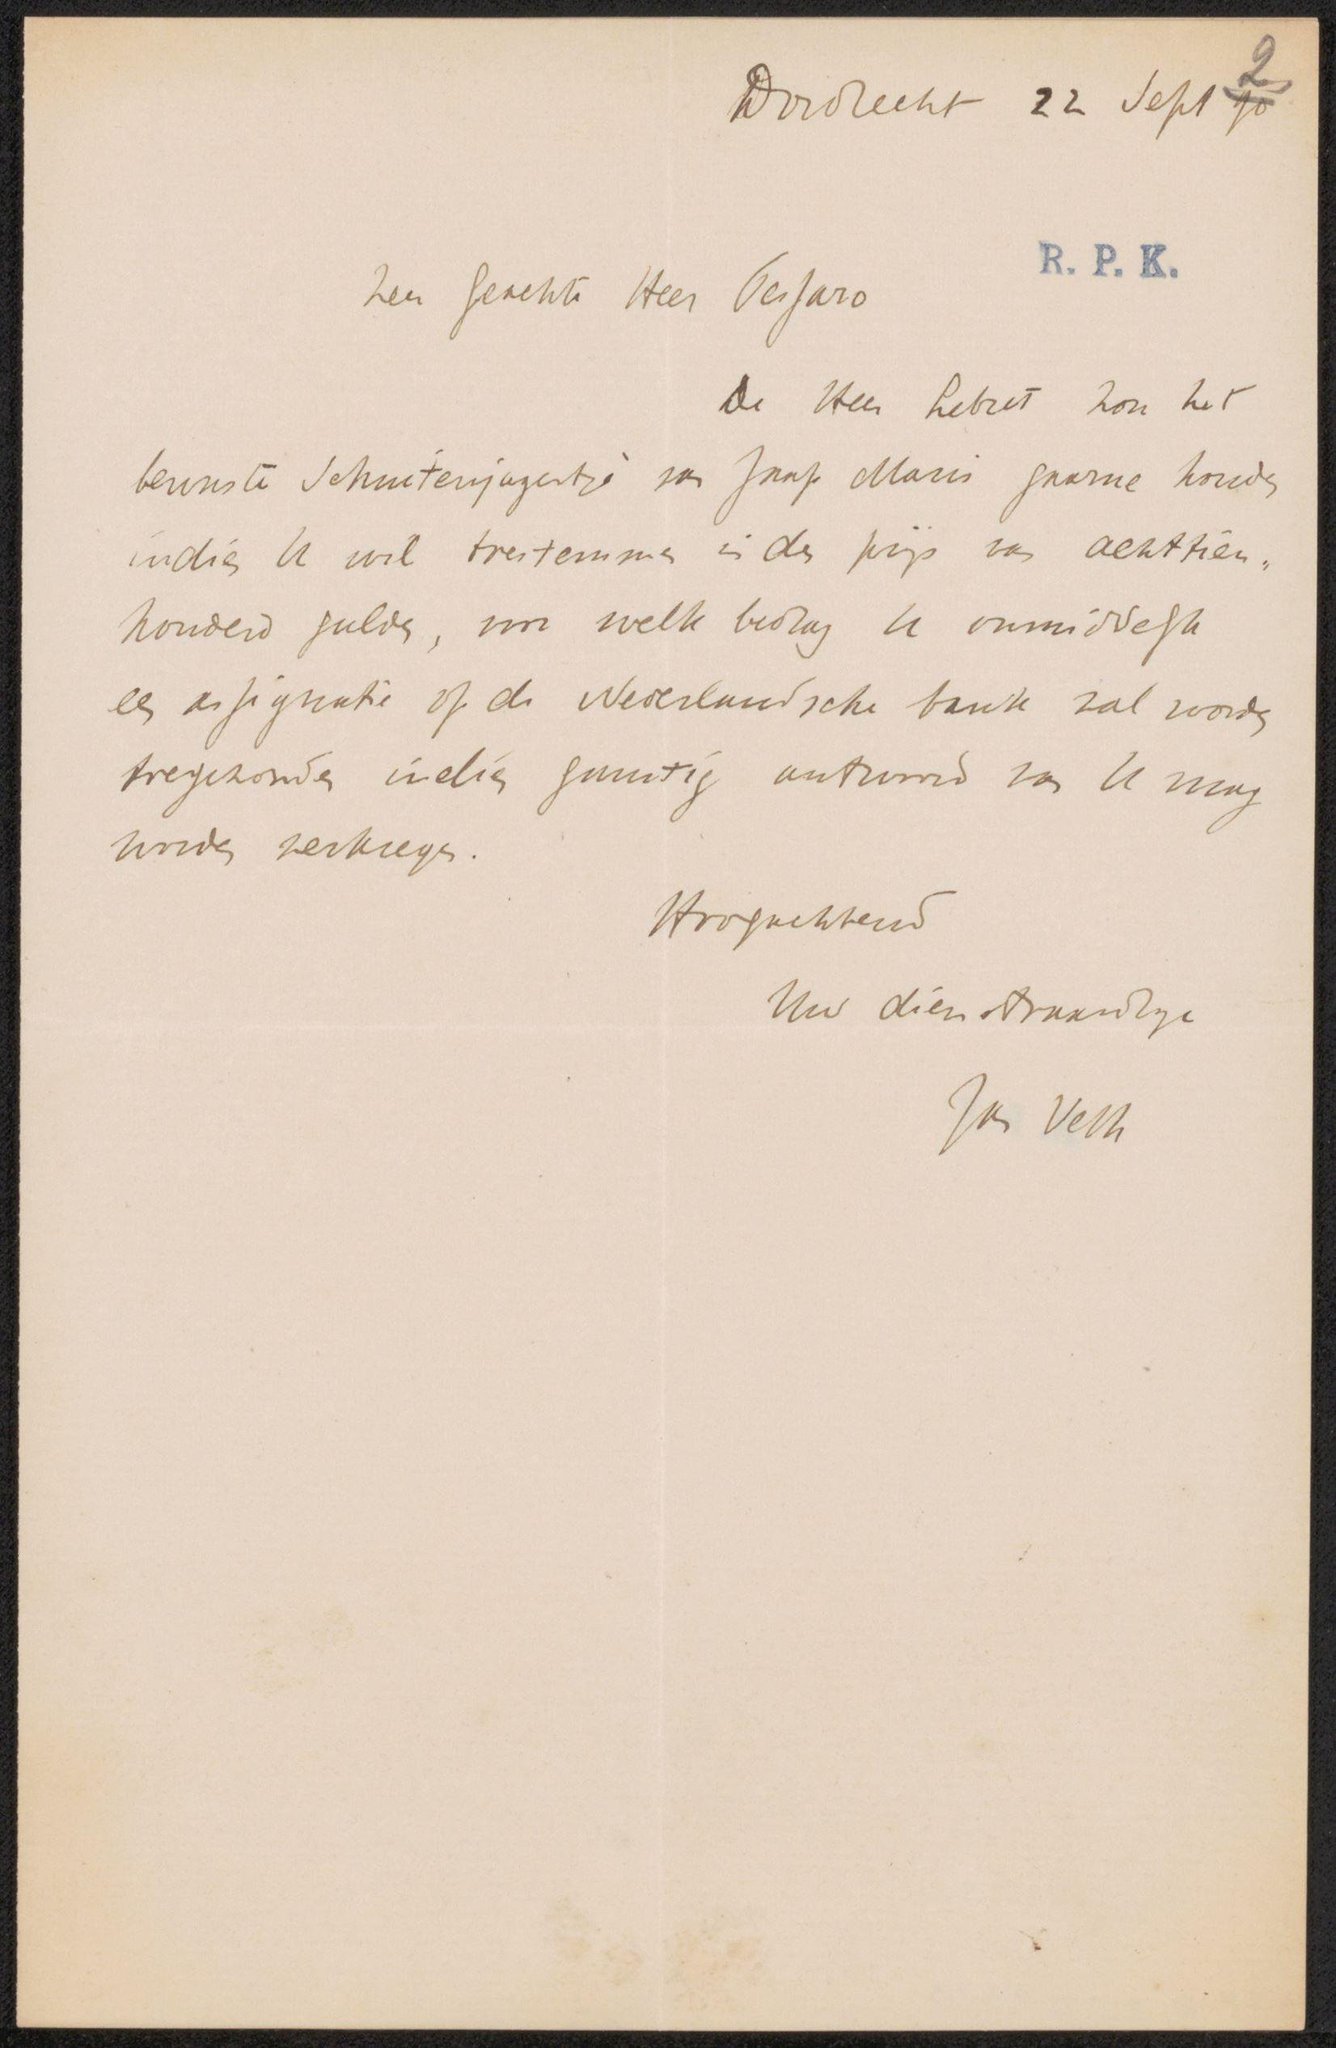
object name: letter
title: Brief aan Filippo Tessaro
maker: jan veth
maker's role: designer, draughtsman, painter, print maker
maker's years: 1864-1925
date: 1890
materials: ink, paper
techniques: pen, writing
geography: dordrecht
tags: painter, print maker, draughtsman, jacob maris, dordrecht, martinus cornelis lebret, art trade, art shop, money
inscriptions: collector's mark: Lugt 2233